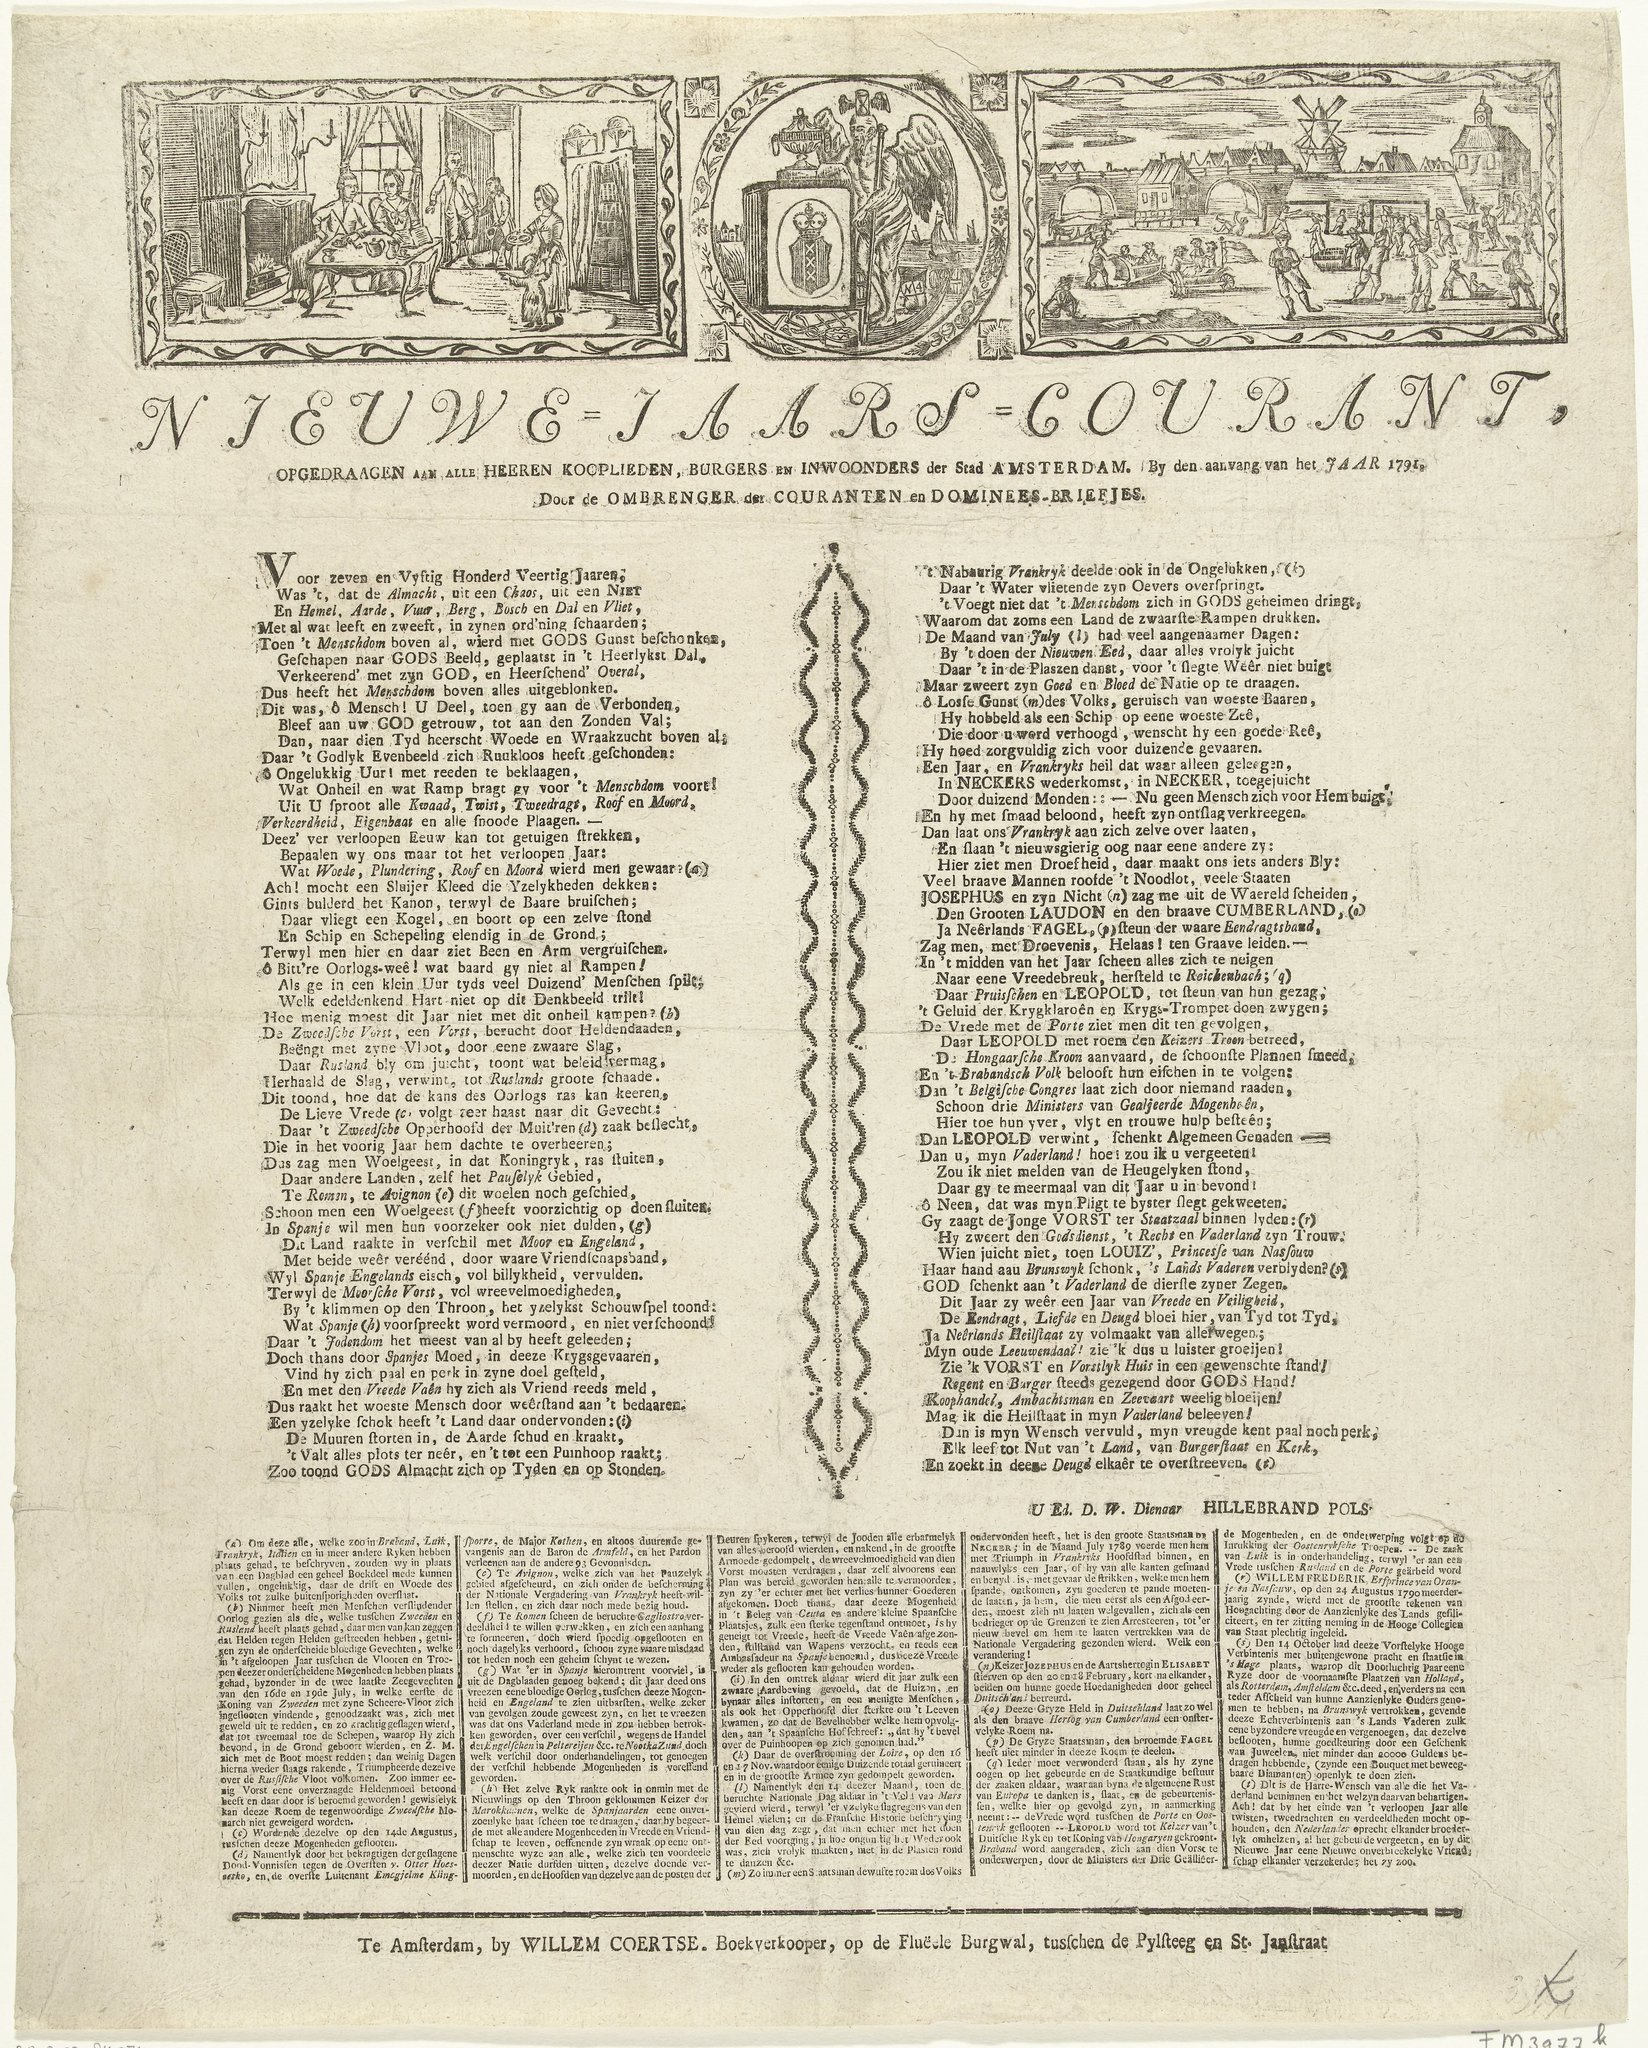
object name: print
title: Nieuwjaarsprent van de Amsterdamse courantbezorgers voor het jaar 1791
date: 1790-1791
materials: paper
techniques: letterpress printing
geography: amsterdam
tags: winter sports, father time, man with wings and scythe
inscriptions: collector's mark: Lugt 2228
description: Nieuwjaarsprent van de Amsterdamse courantbezorger Hillebrand Pols voor het jaar 1791, opgedragen aan de burgers van Amsterdam. Bovenaan in het midden een vignet met Vader Tijd en het stadswapen, links een huiskamer met familie, rechts een stadsgezicht met ijsvermaak. Onder de voorstellingen een vers in twee kolommen met onderaan in vijf kolommen een overzicht van de belangrijkste gebeurtenissen uit het afgelopen jaar.